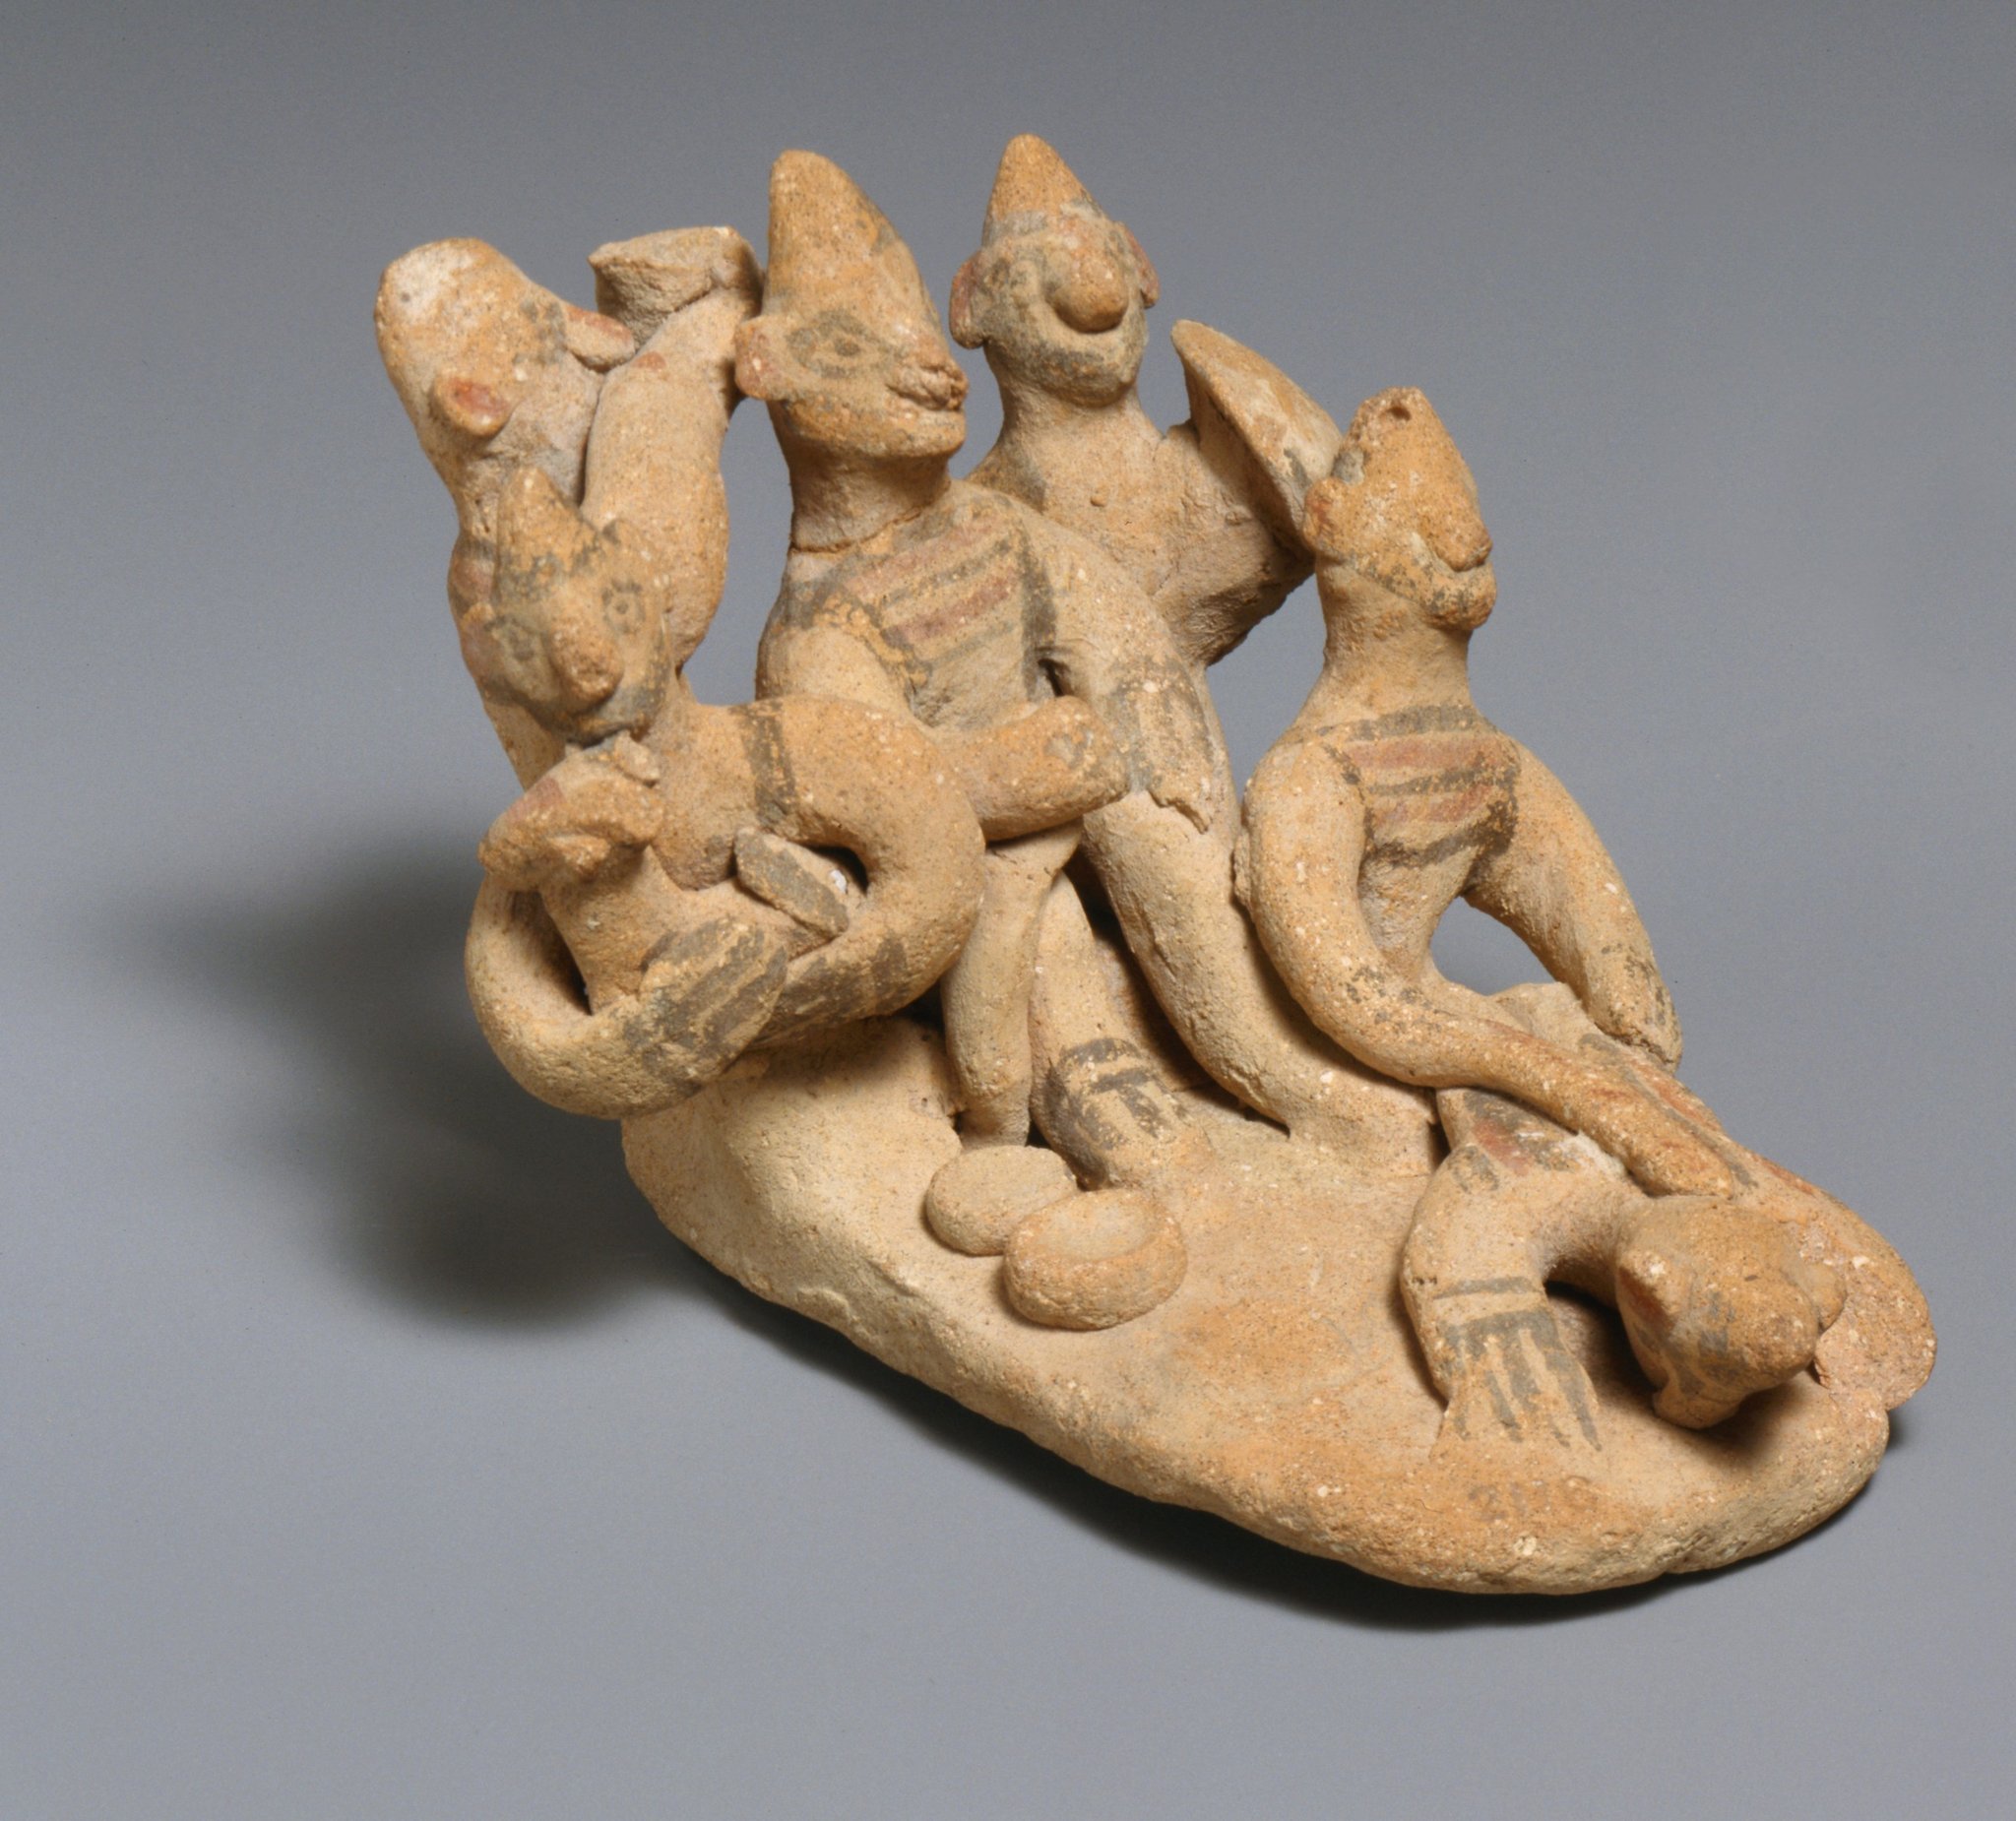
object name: statuette group of six figure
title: Terracotta group: scene of punishment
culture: cypriot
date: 600-501 BCE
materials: terracotta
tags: human figures